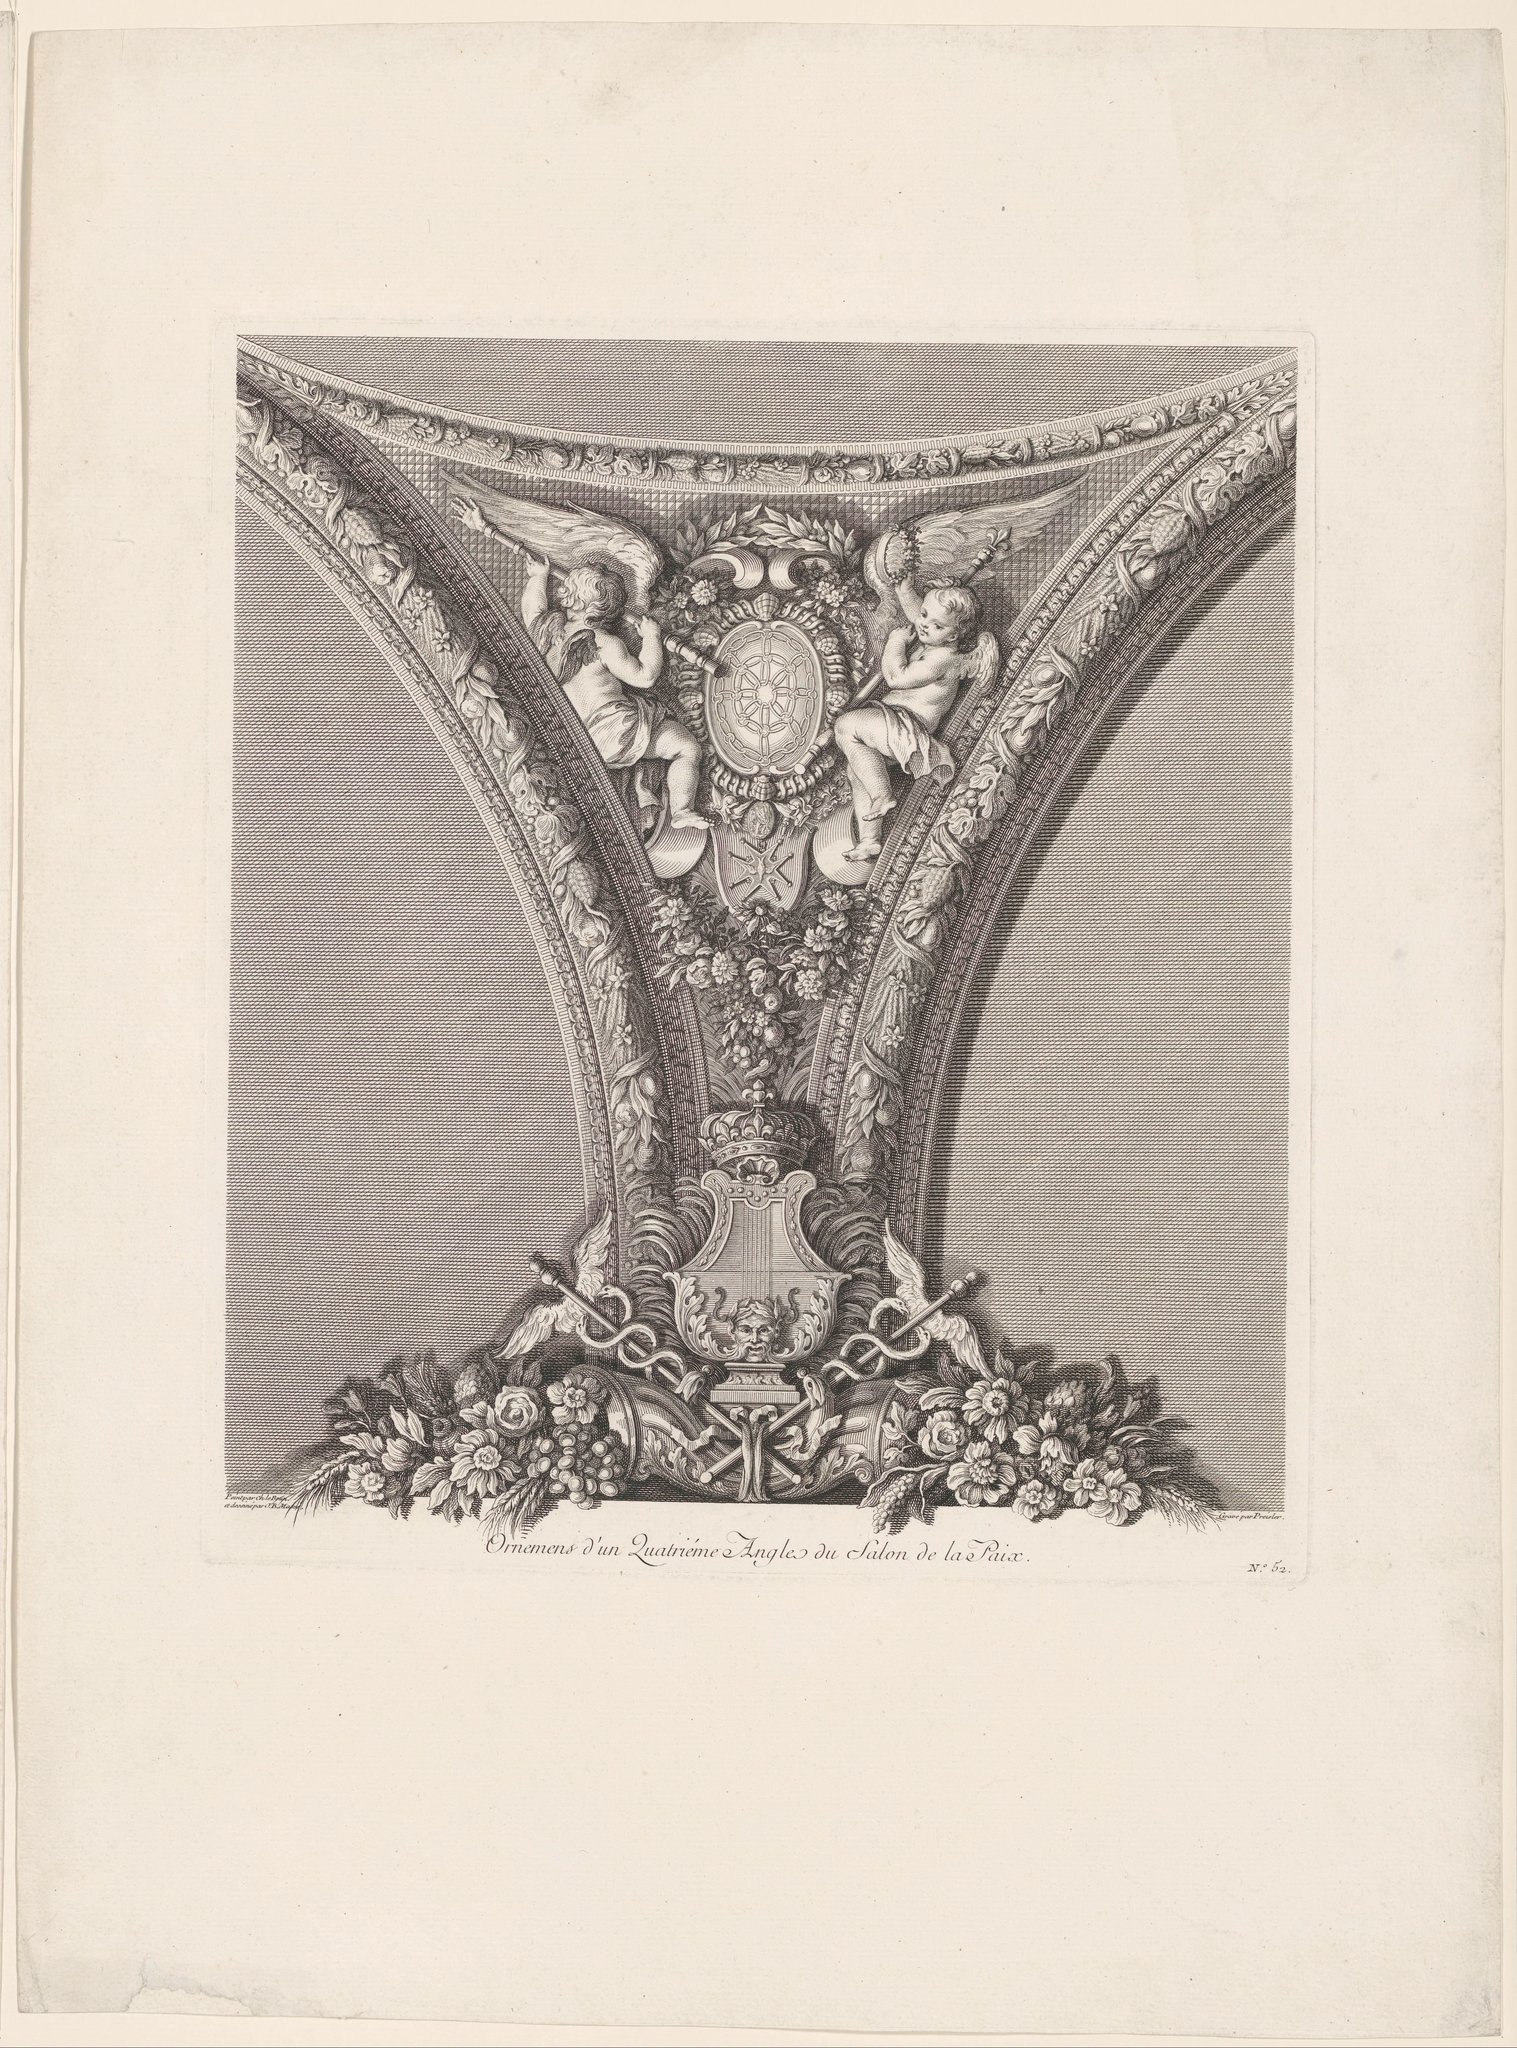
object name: print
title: Werken van Charles le Brun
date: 1752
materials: paper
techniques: engraving, etching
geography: paris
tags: (decorated) ceiling, caduceus (staff with two snakes, attribute of mercury), cupids: 'amores', 'amoretti', 'putti'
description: Prent uit: Massé, Jean Baptiste. La Grande Galerie de Versailles, et les deux salons qui l'accompagnent, peints par Charles le Brun premier peintre de Louis XIV, dessinés par Jean- Baptiste Masse peintre et conseiller de l'Academie royale de peinture & sculpture; et gravés sous ses yeux par les meilleurs maitres du tems. Parijs: Imprimerie Royale, 1752.